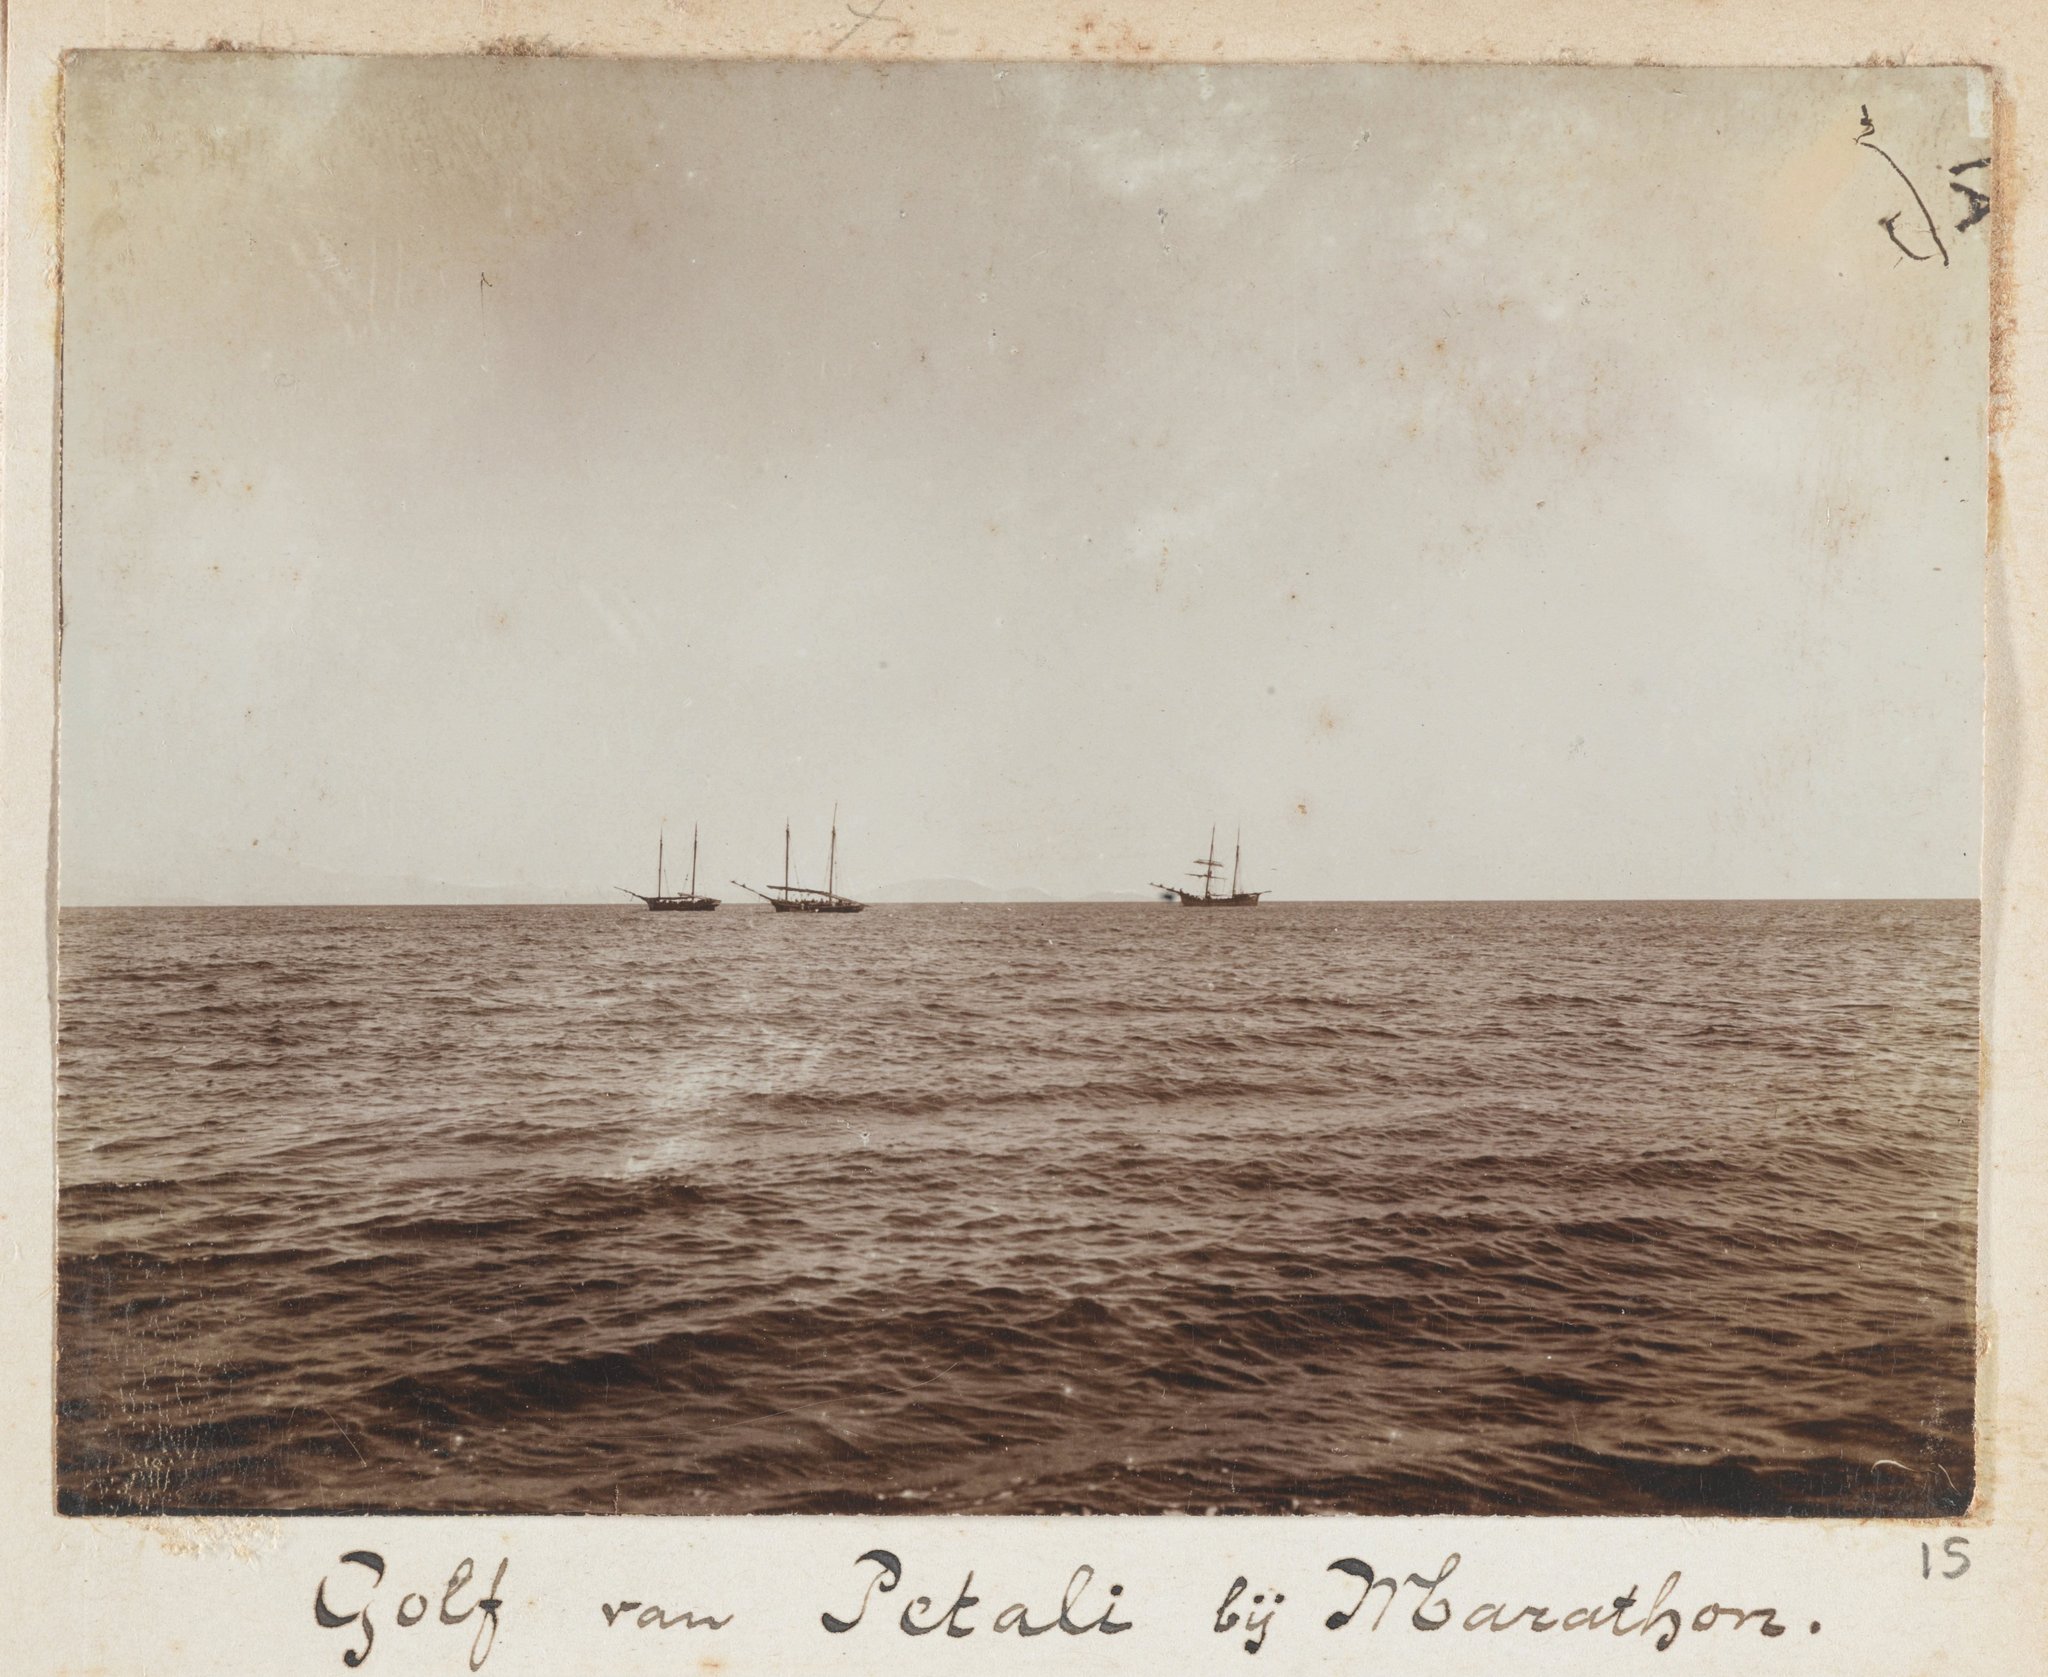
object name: photograph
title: Golf van Petali bij Marathon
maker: johannes lodewijk heldring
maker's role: fotograaf, predikant, schrijver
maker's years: 1852-1923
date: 1898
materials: paper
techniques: collodion silver print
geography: attica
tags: sea (seascape), ships (in general) - cc - more than one ship, petalioi gulf